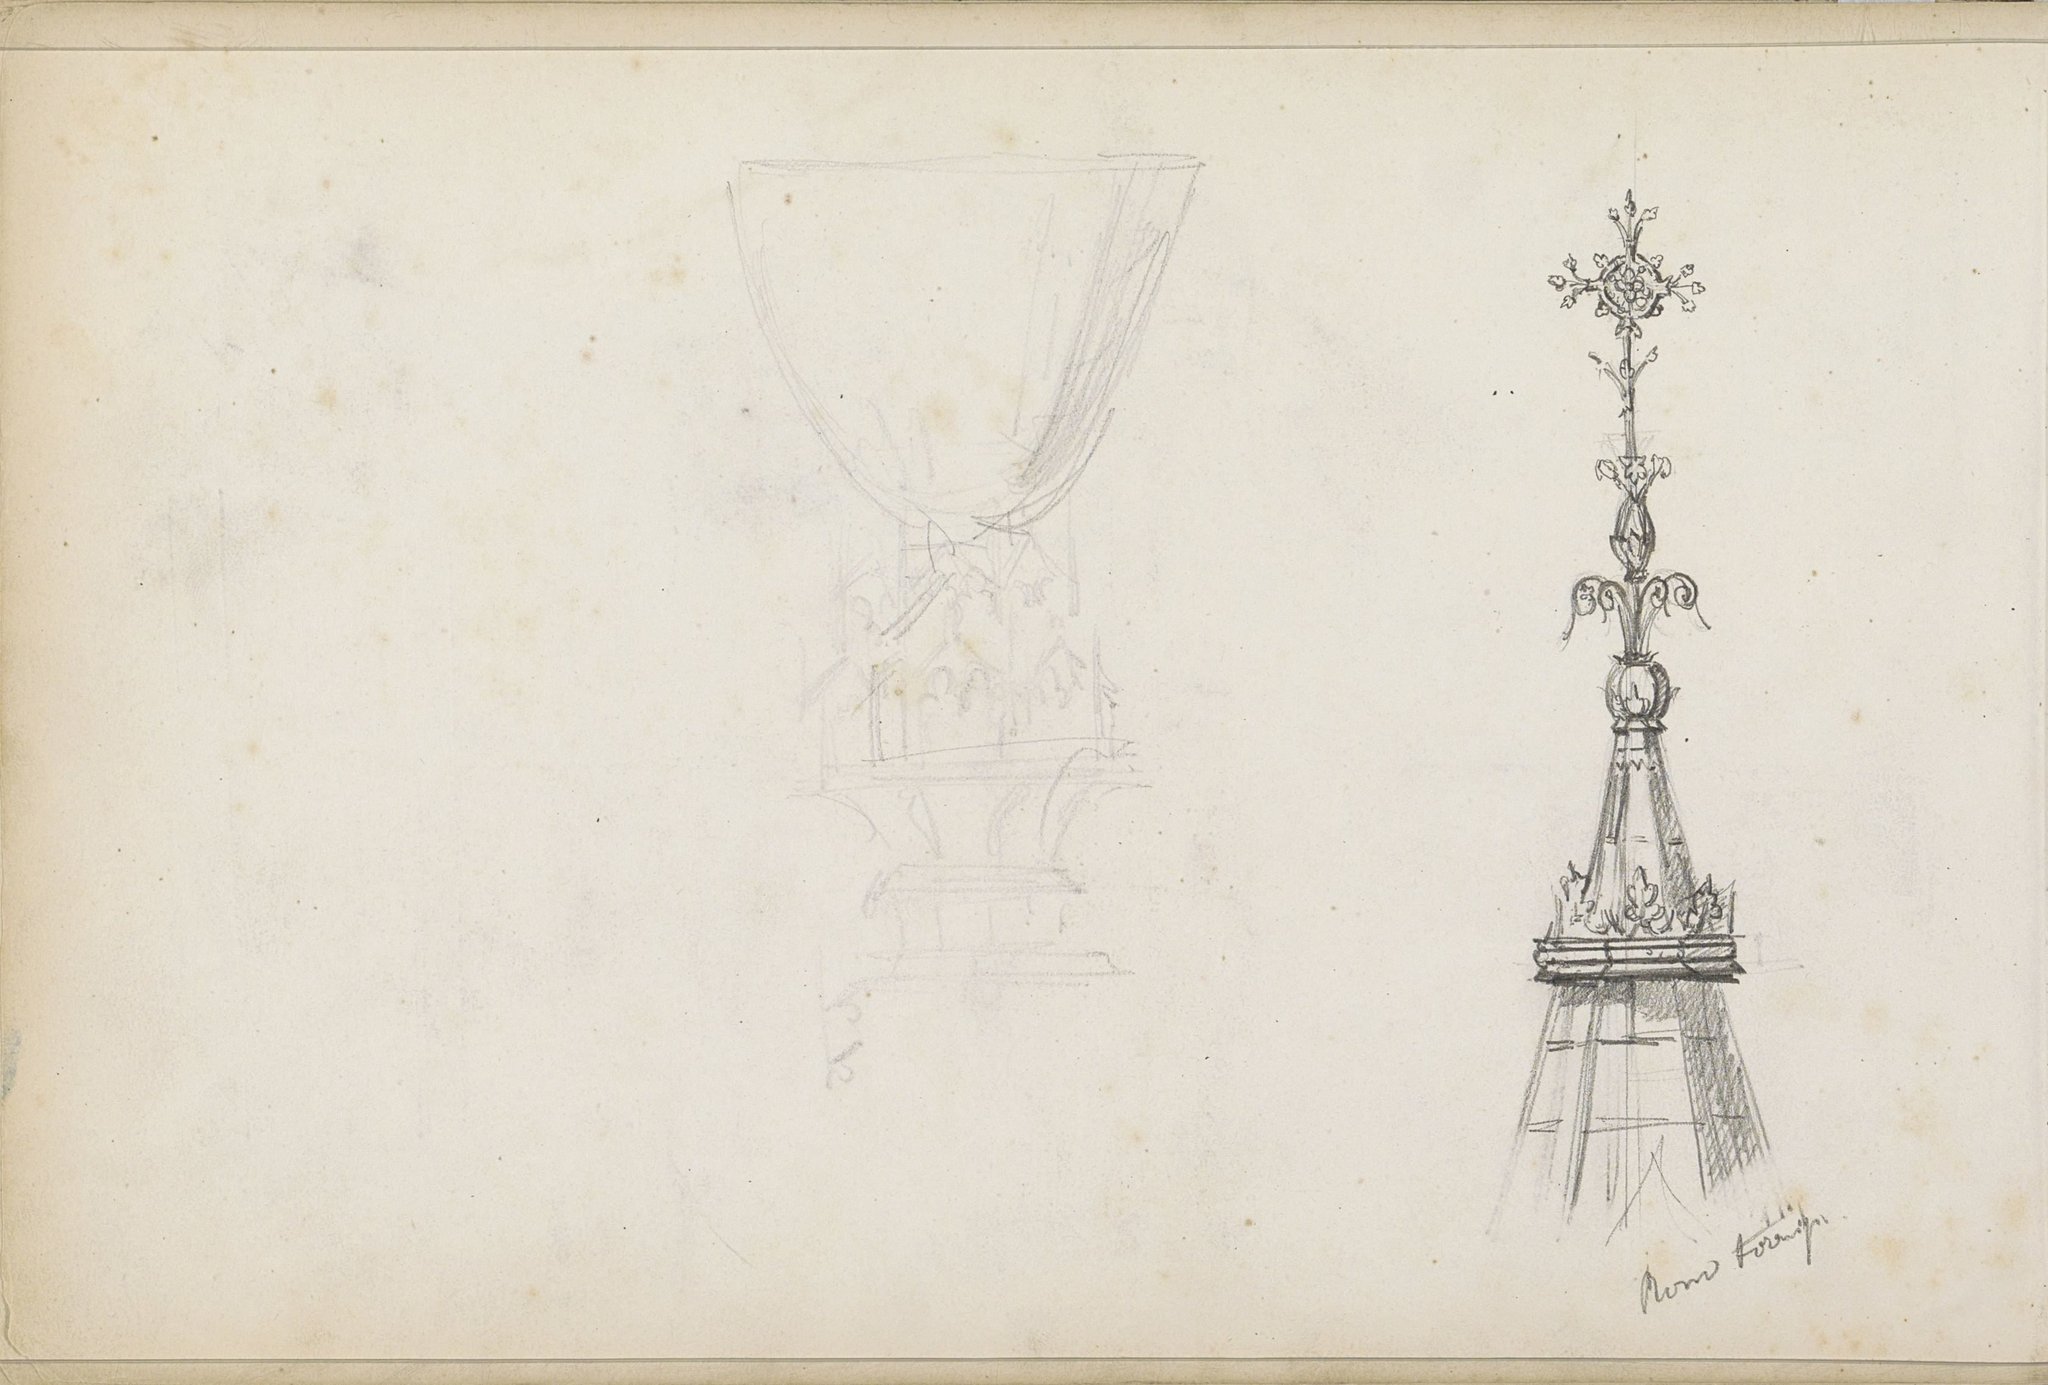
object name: sketchbook leaf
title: Kelk op een sokkel en een Romeinse torenspits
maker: isaac gosschalk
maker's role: draughtsman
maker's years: 1838-1907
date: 1862-1867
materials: paper, pencil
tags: chalice, parts of church exterior and annexes: spire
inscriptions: annotation: ‘Rom torensp.’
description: Blad 7 verso uit een schetsboek met 58 bladen.